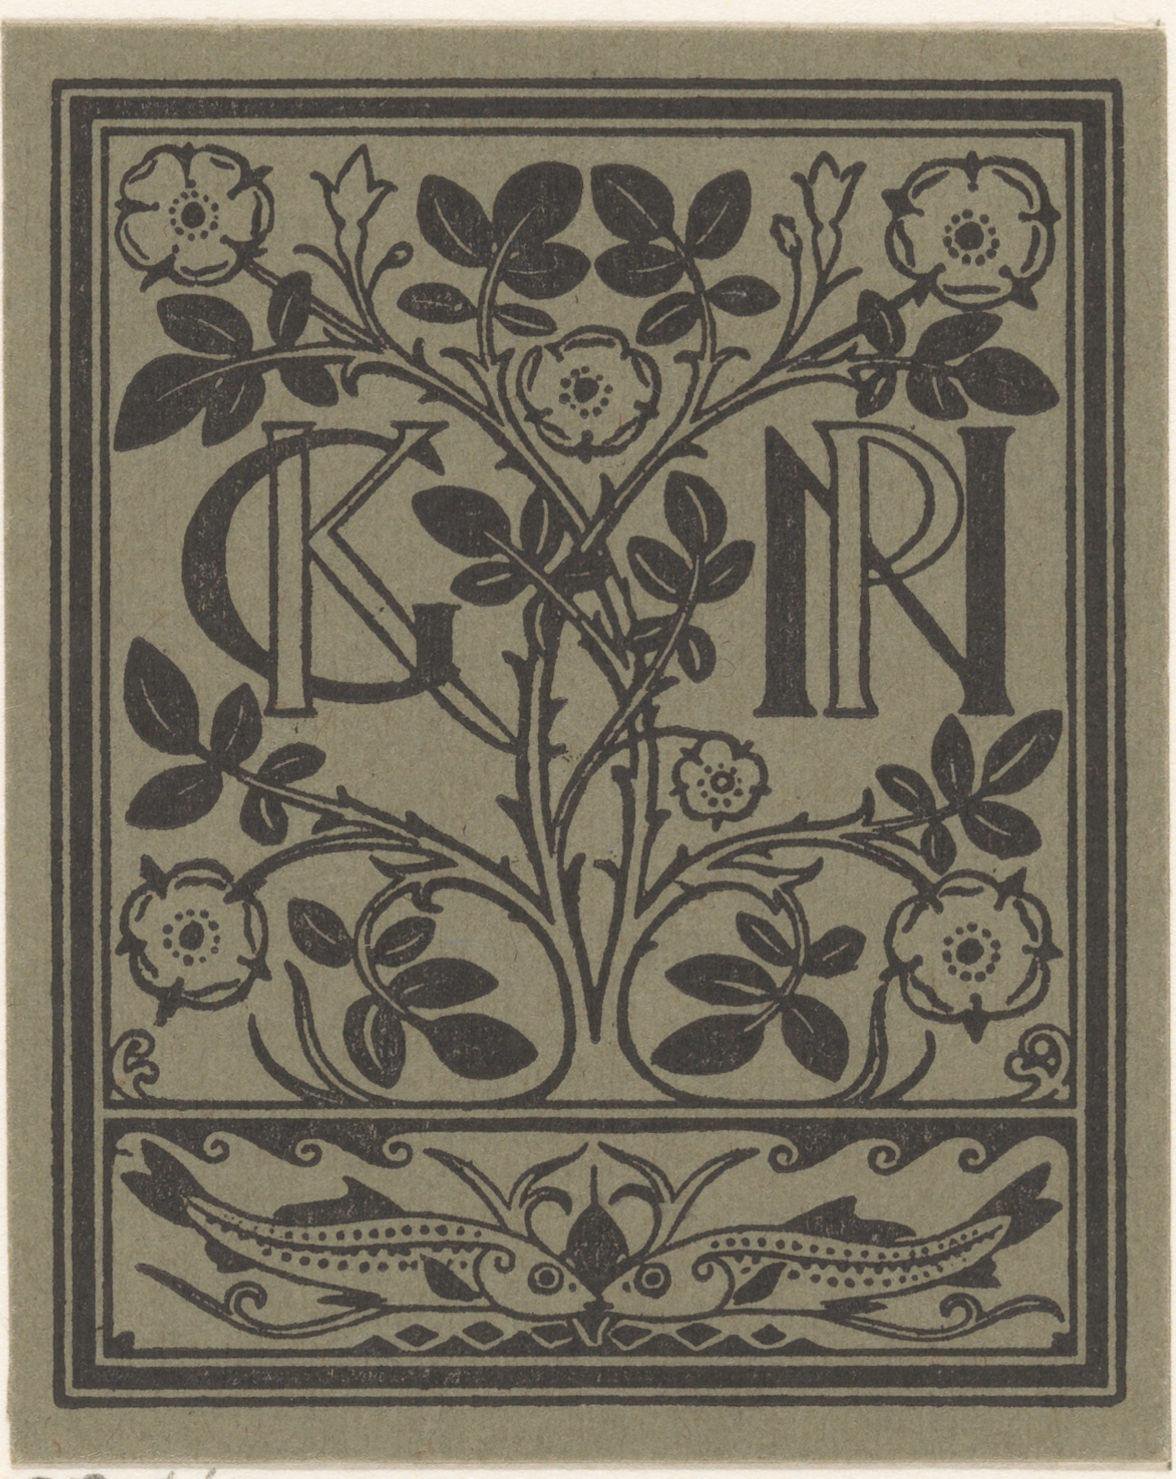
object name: print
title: Ex libris voor Klaas Groesbeek en Paul Nijhoff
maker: gerrit willem dijsselhof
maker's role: designer, draughtsman, print maker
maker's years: 1866-1924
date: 1876-1924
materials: paper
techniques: woodcut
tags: klaas groesbeek, fishes, shrubs: rose-bush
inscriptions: collector's mark: Lugt 2228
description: De initialen van Klaas Groesbeek en Paul Nijhoff, de directeuren van boekhandel Scheltema & Holkema in Amsterdam, in een rechthoek die verder is opgevuld met een rozenstruik en twee vissen.